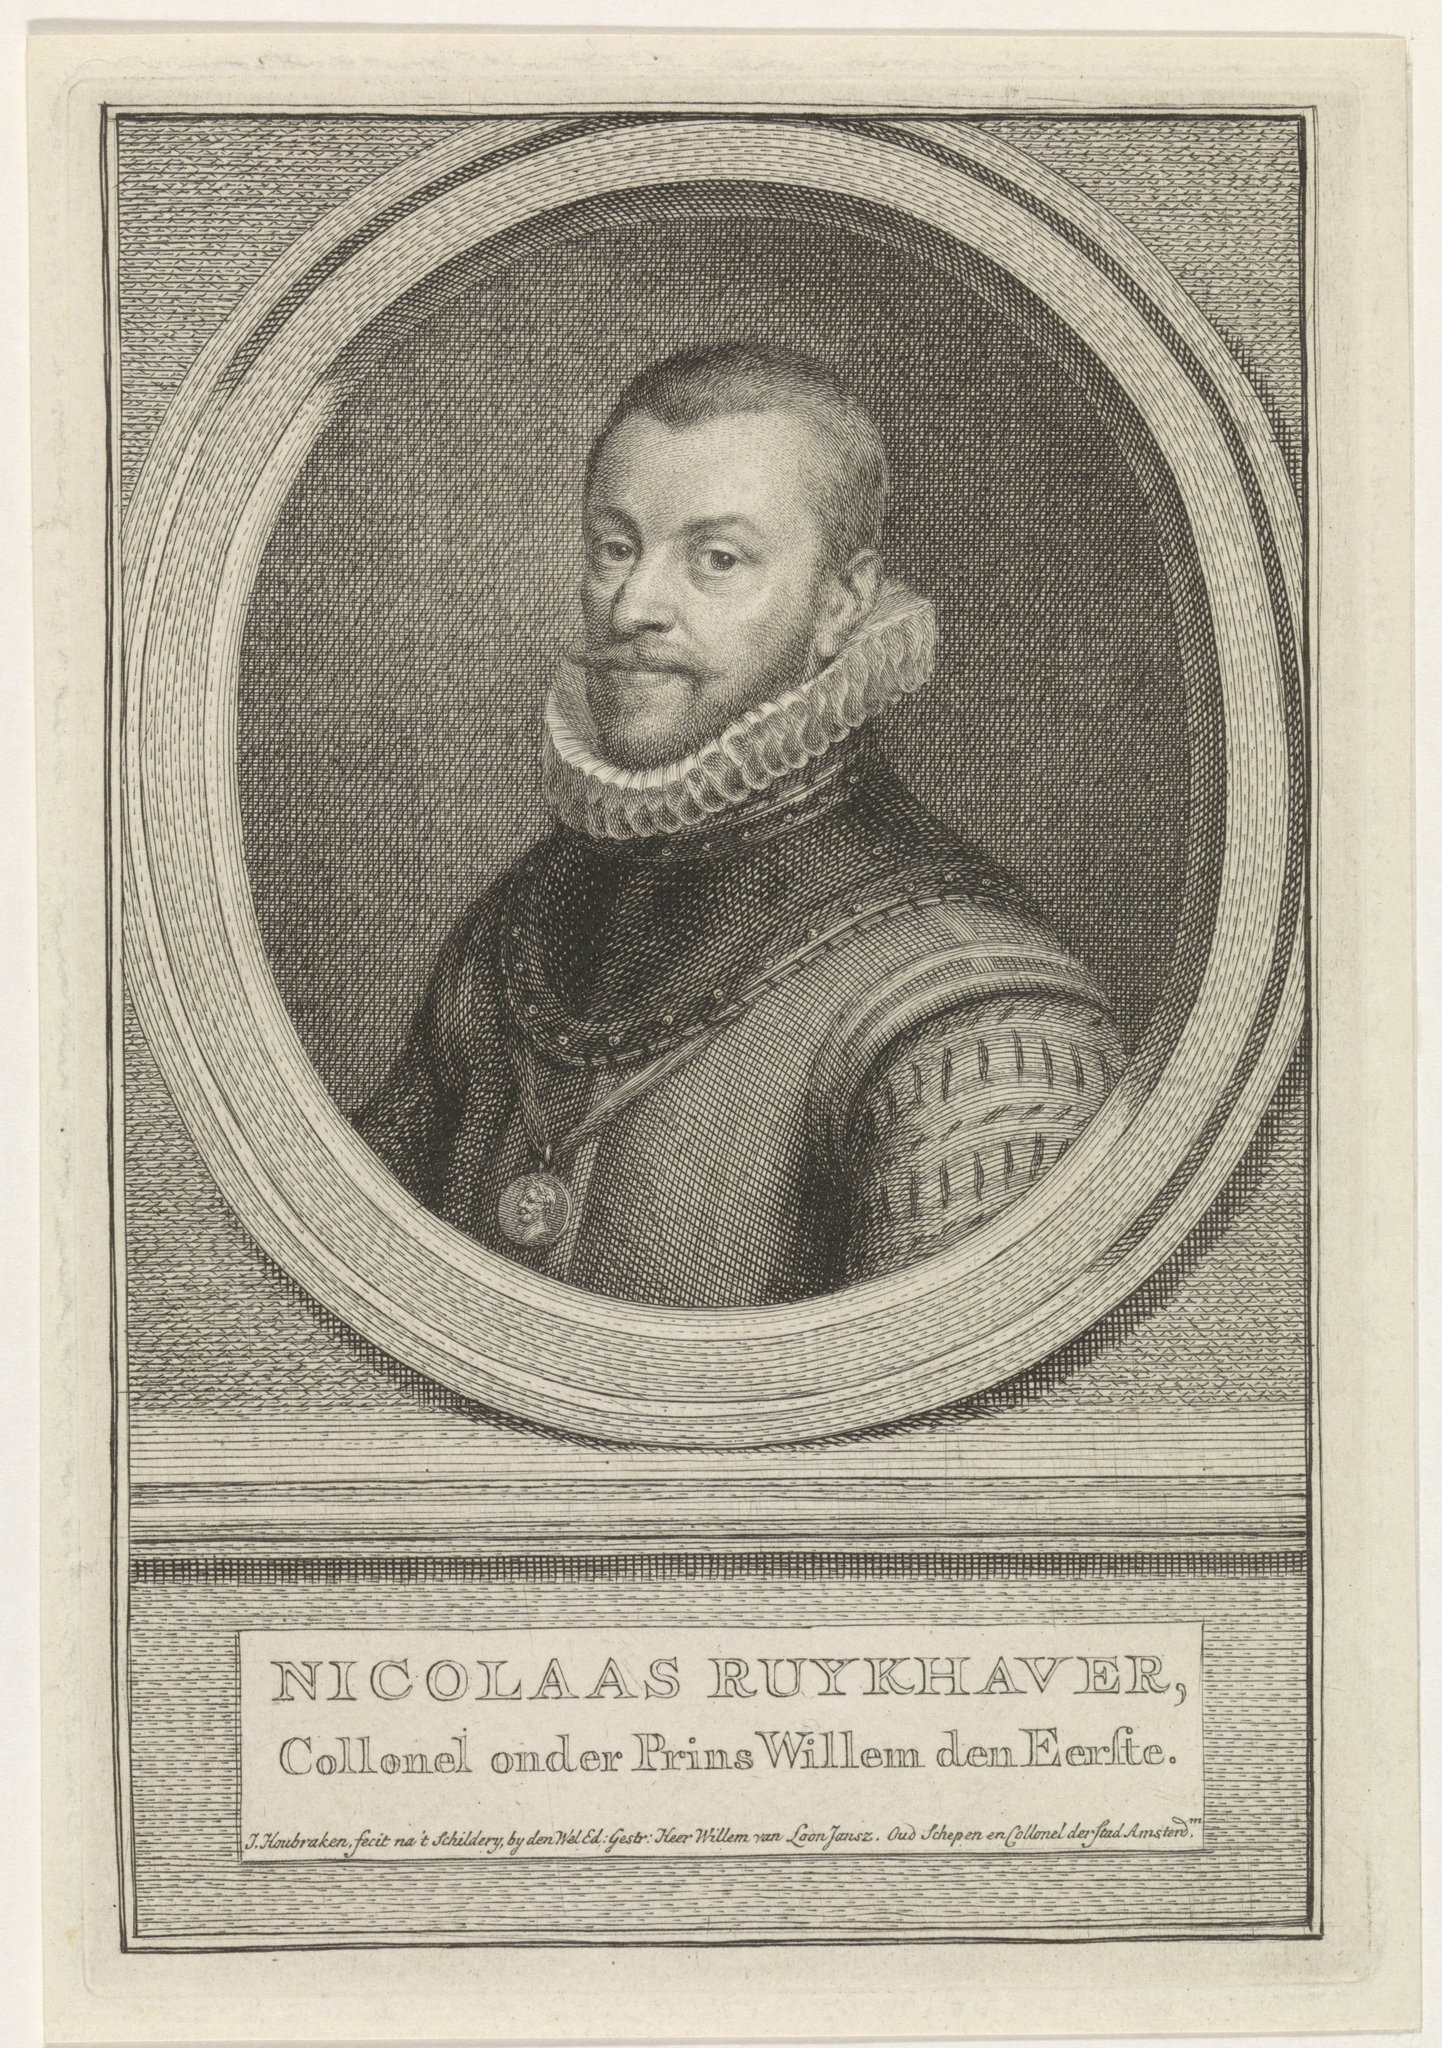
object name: print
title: Nicolaas Ruykhaver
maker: jacob houbraken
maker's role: draughtsman, print maker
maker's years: 1698-1780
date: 1749-1759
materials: paper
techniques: engraving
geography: amsterdam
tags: haarlem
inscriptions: collector's mark: Lugt 240, collector's mark: Lugt 2228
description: Prent oorspronkelijk bedoeld voor: Jan Wagenaar, Vaderlandsche historie, vervattende de geschiedenissen der nu Vereenigde Nederlanden, inzonderheid die van Holland (...), 21 delen. Amsterdam, Isaak Tirion, 1749-59.